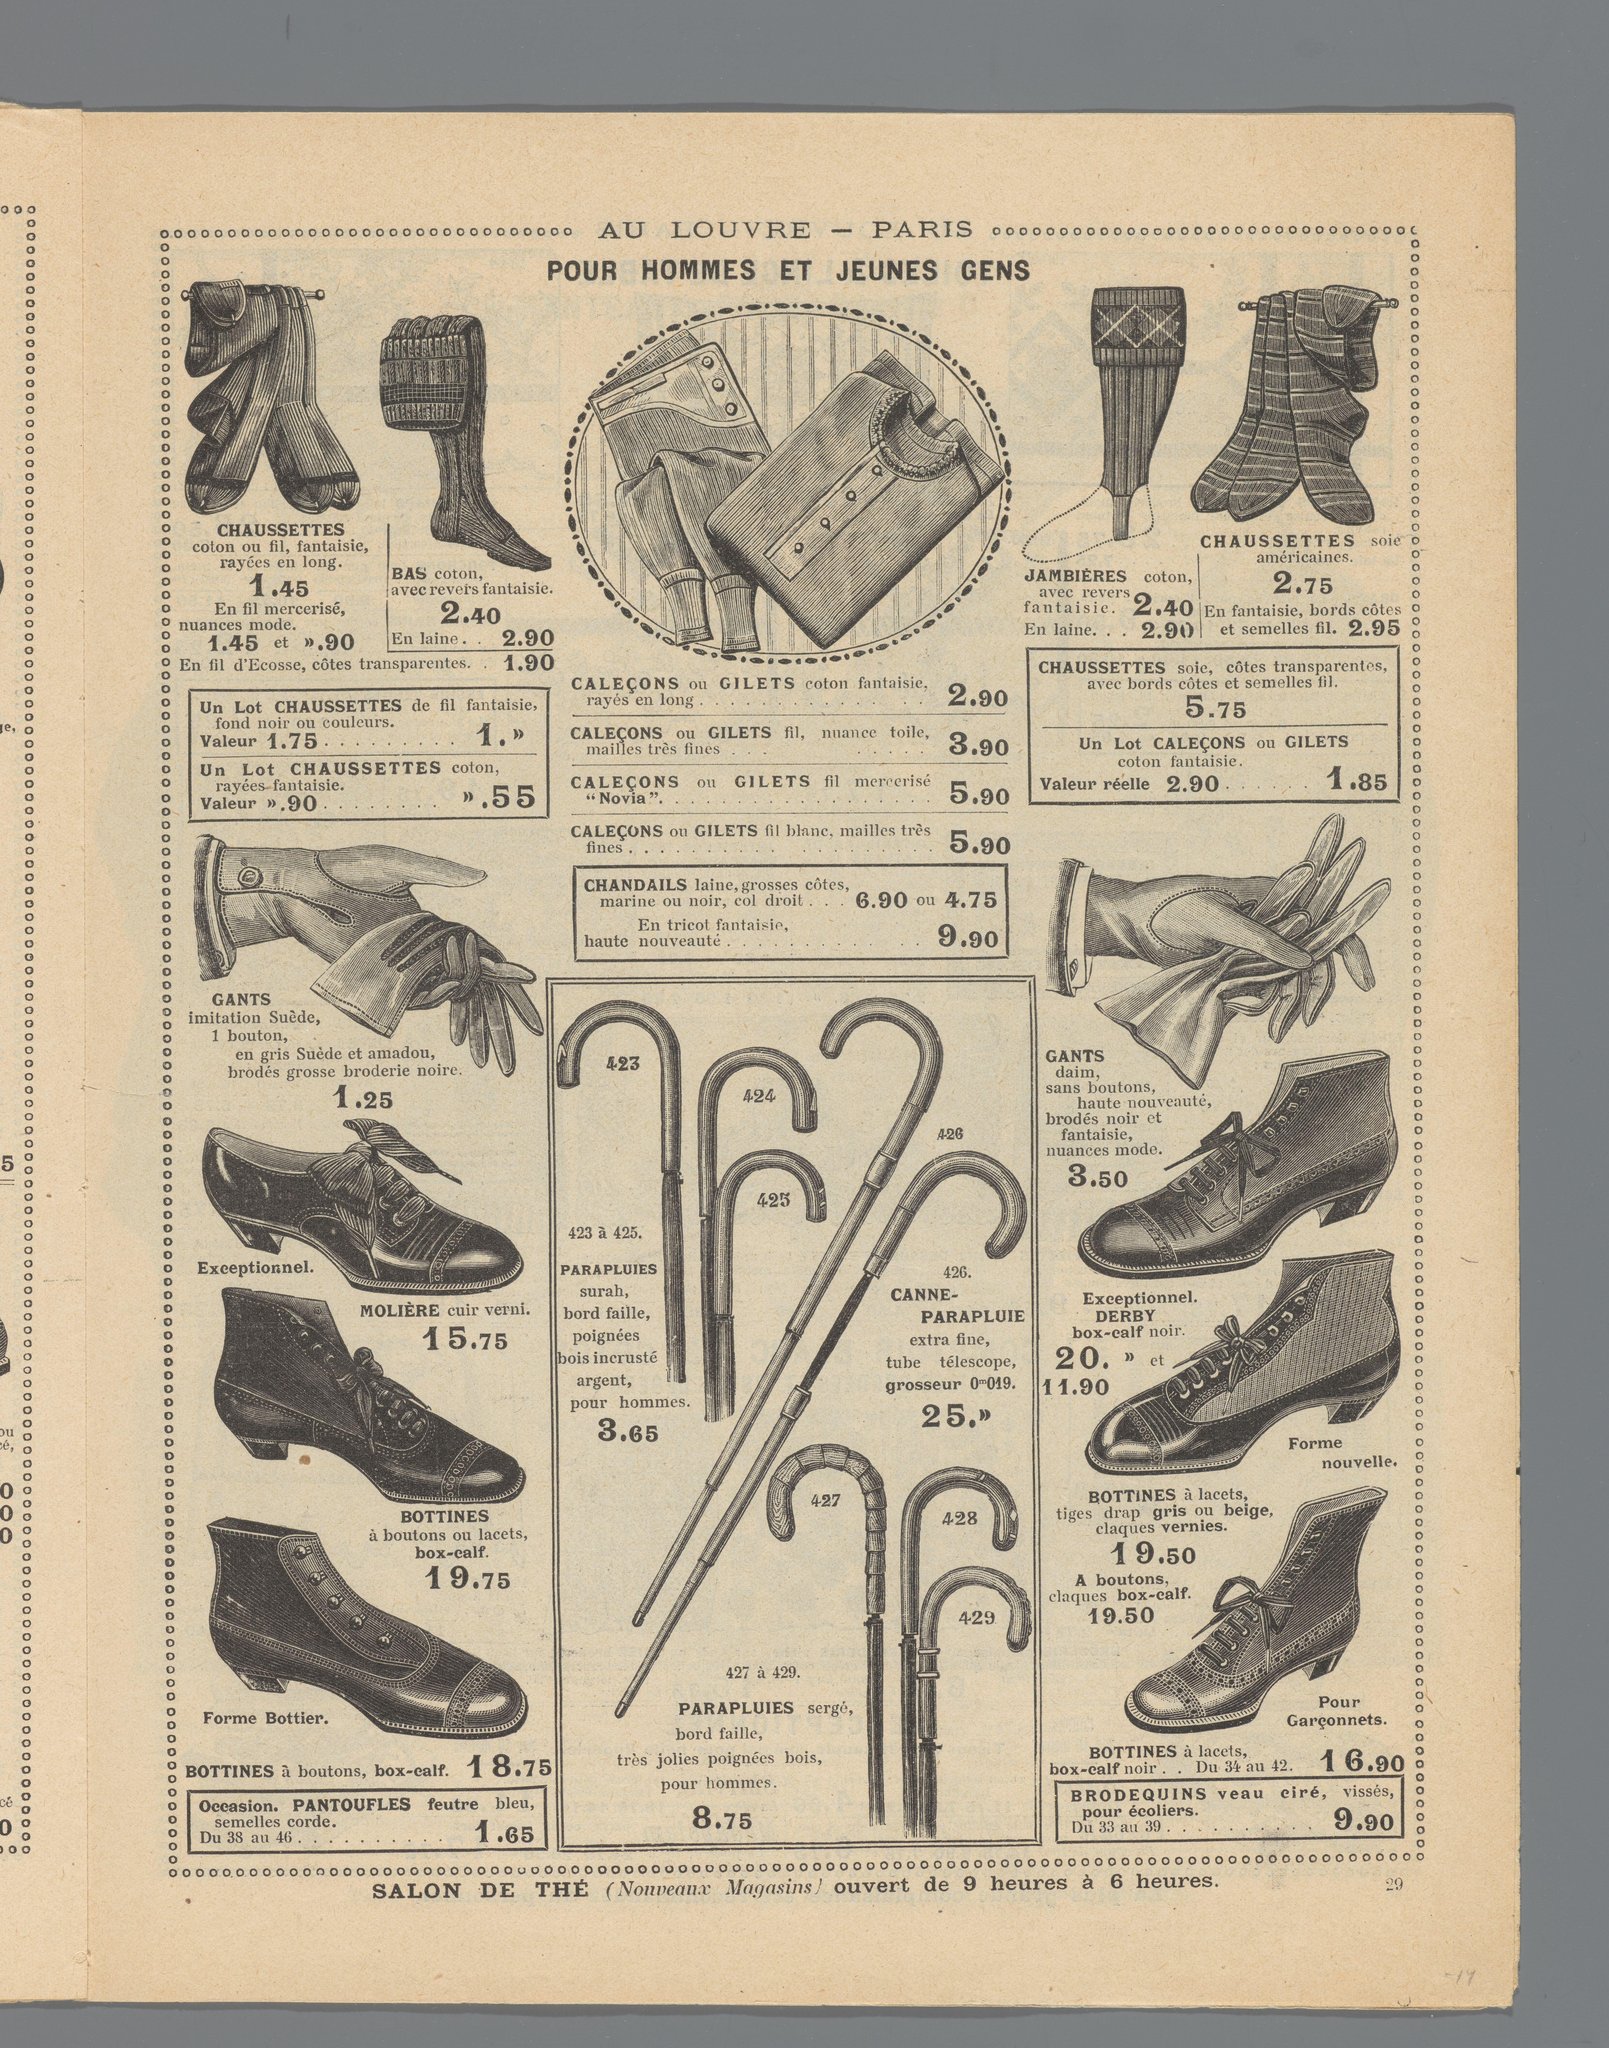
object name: print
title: Au Louvre, Paris: Lundi 2 Mars: Nouveautés d'été: p. 29: (Chaussures) pour hommes et jeunes gens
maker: Anonymous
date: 1913-1915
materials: paper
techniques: photography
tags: fashion plates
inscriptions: title, caption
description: Pagina in "Au Louvre - Paris" : schoenen voor heren en jongens, handschoenen en wandelstokken.